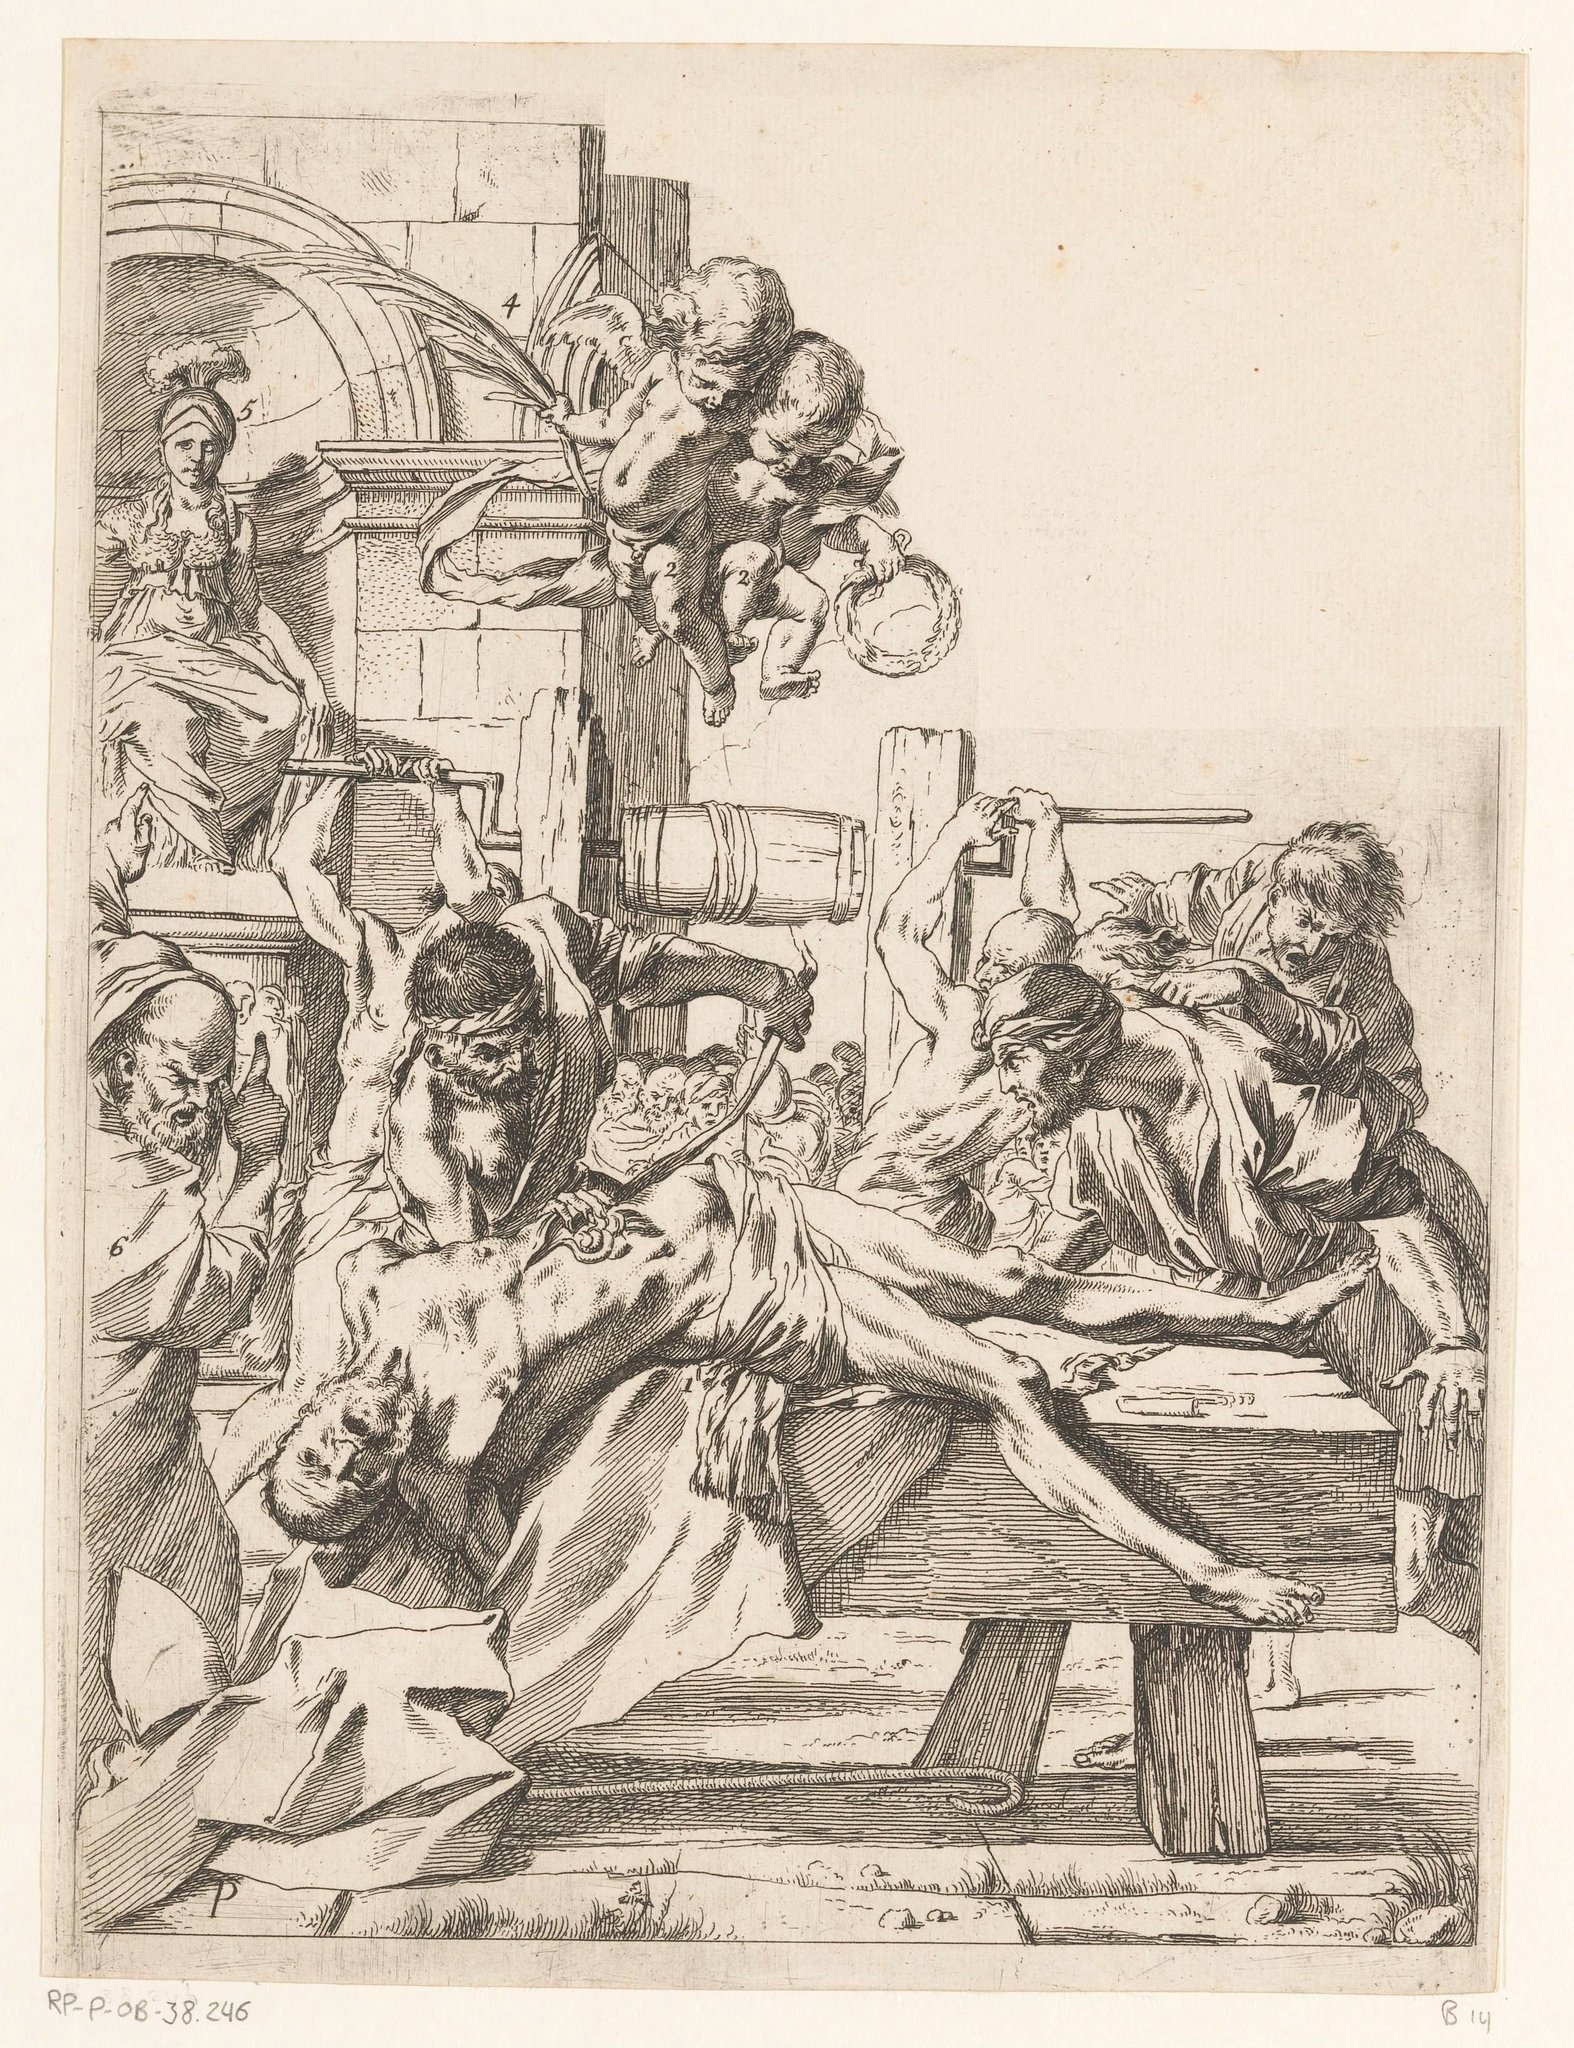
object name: print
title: Martelaarschap van Erasmus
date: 1630-1631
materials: paper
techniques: etching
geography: italy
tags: angels crowning and/or bringing palm-branches, st. erasmus lies naked on a block; his bowels are wound on to a windlass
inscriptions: collector's mark: Lugt 240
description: De heilige Erasmus liggend terwijl beulen met een windas de ingewanden uit zijn lichaam trekken. Op de achtergrond een toekijkende menigte en in de lucht twee putti met een krans en een palmtak. Sommige figuren in de voorstelling zijn genummerd.